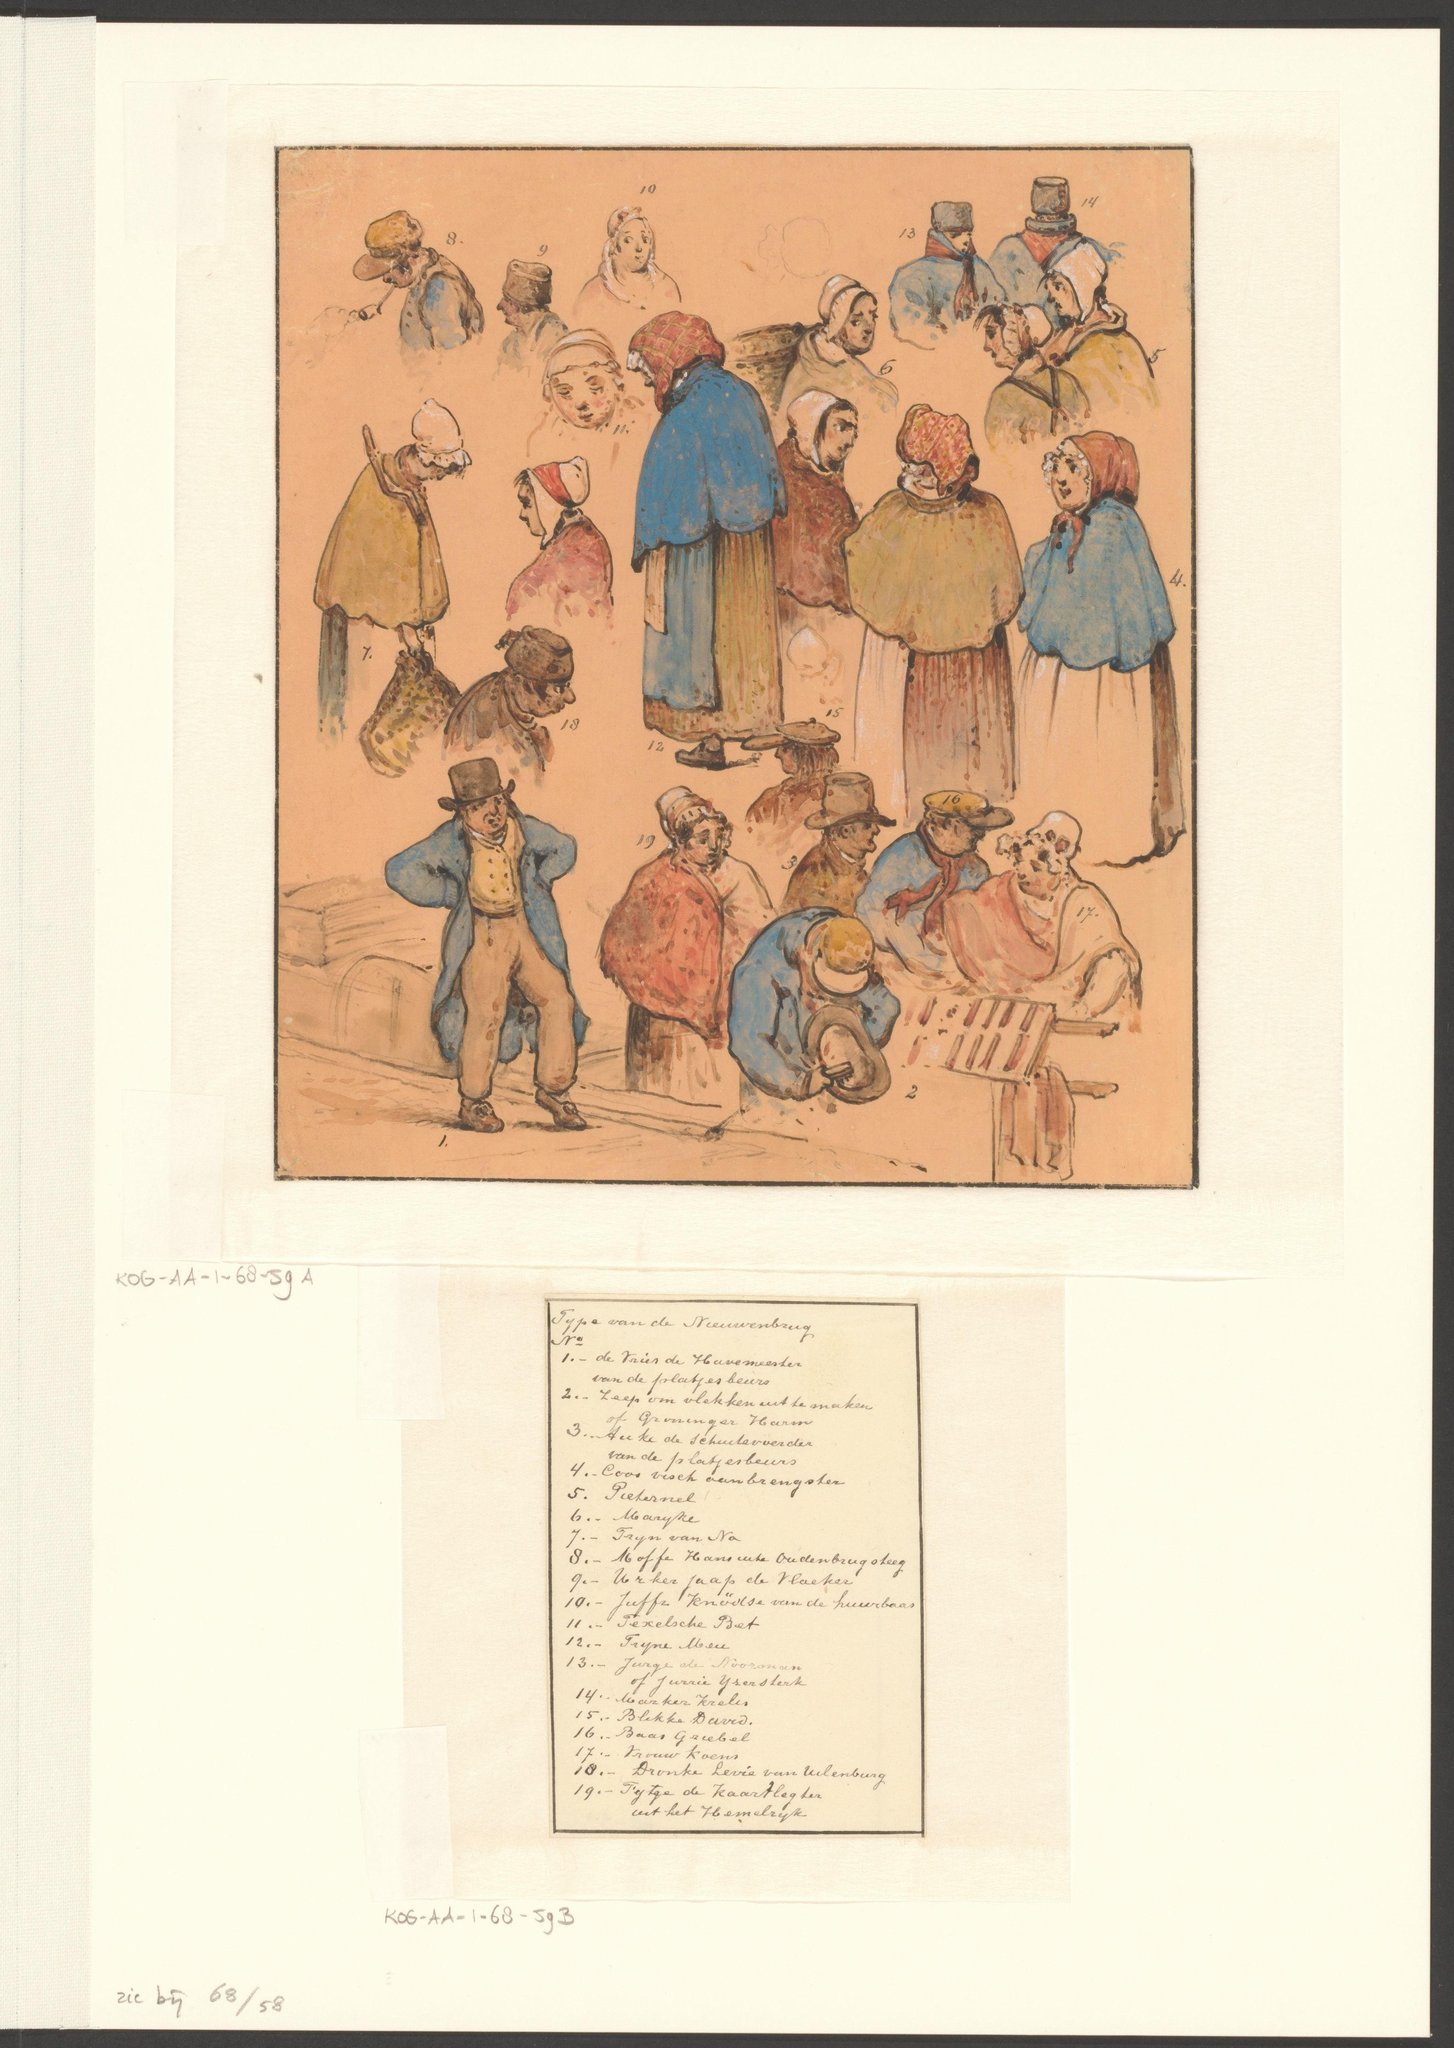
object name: drawing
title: Compositie met Amsterdamse volkstypen van de Nieuwenbrug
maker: christiaan andriessen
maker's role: draughtsman, print maker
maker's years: 1775-1846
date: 1785-1846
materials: paint, gouache, ink, paper, pencil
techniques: brush, pen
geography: amsterdam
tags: folk costume, regional costume, amsterdam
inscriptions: inscription: ‘No 1 de Vries haven’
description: Onderwerpsrubriek binnen de Atlas Amsterdam: Amsterdamsche Typen AB - A.